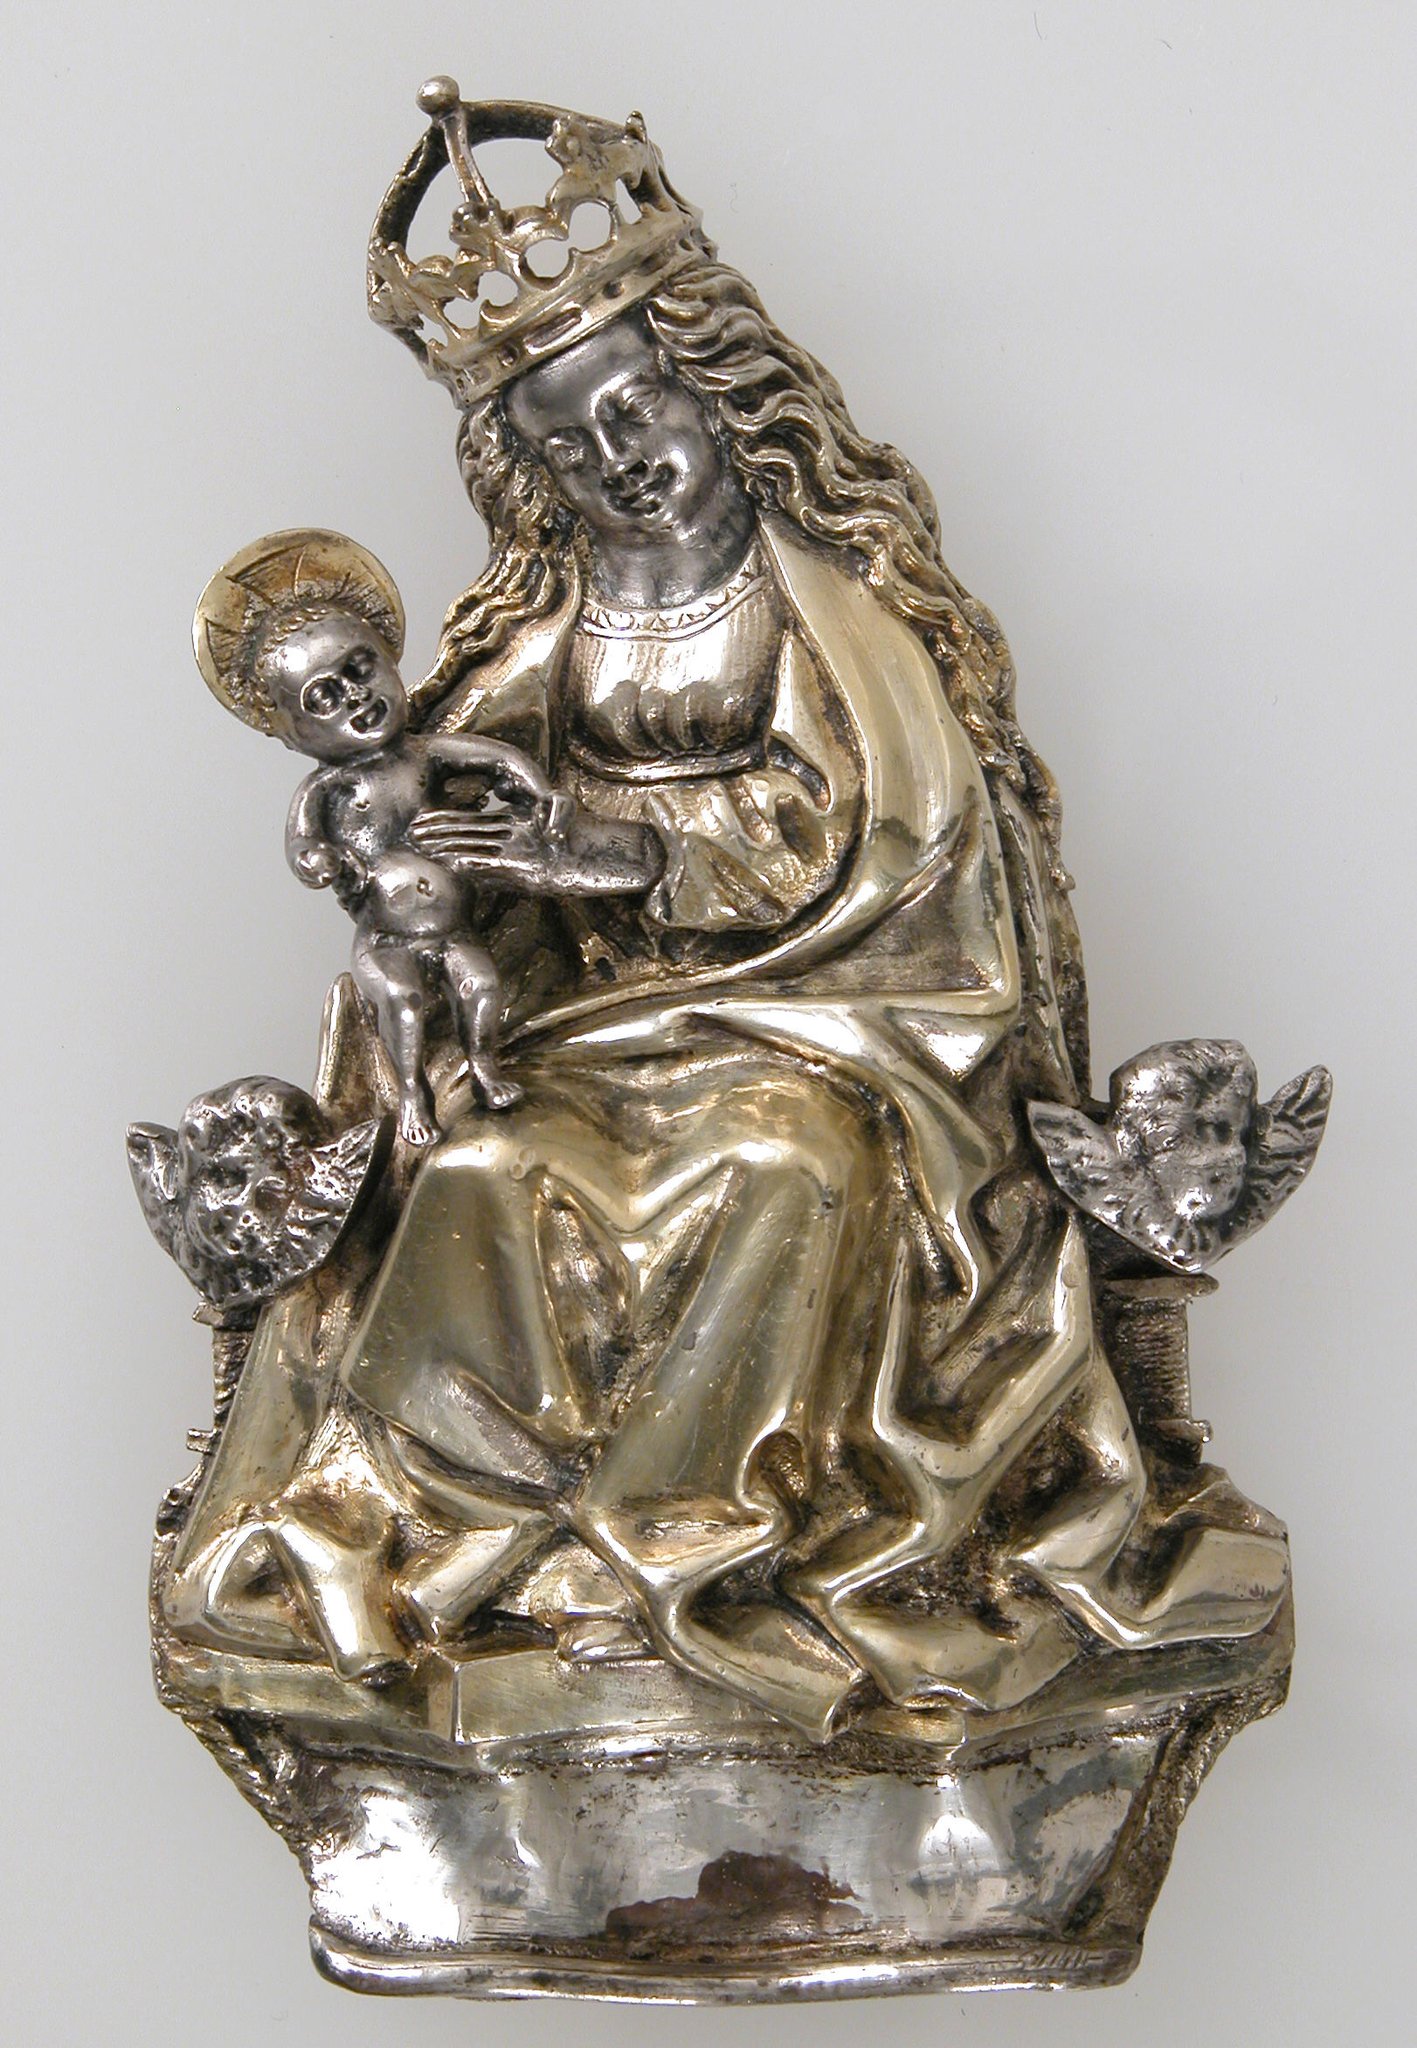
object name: badge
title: Badge with the Virgin and Child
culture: german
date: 1500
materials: gilt, silver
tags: madonna and child